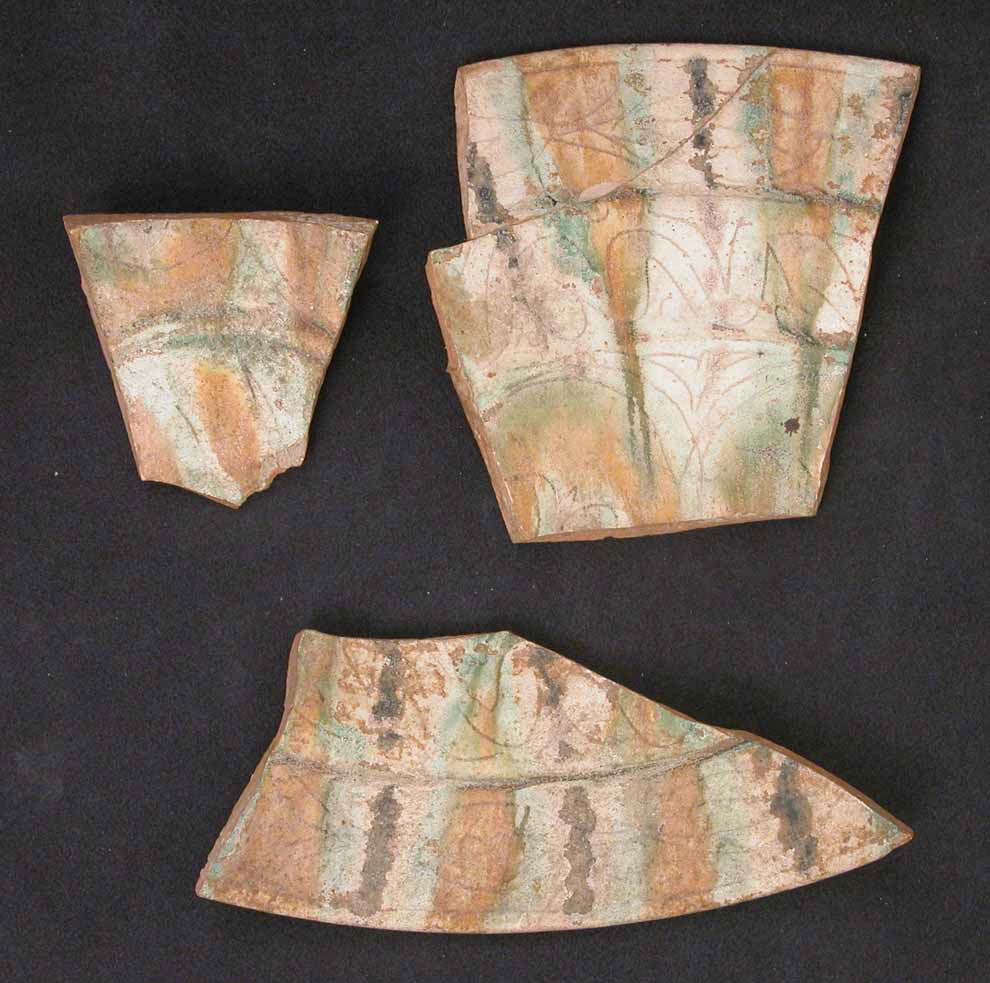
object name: fragment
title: Fragments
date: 801-1000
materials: earthenware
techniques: glazing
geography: iran